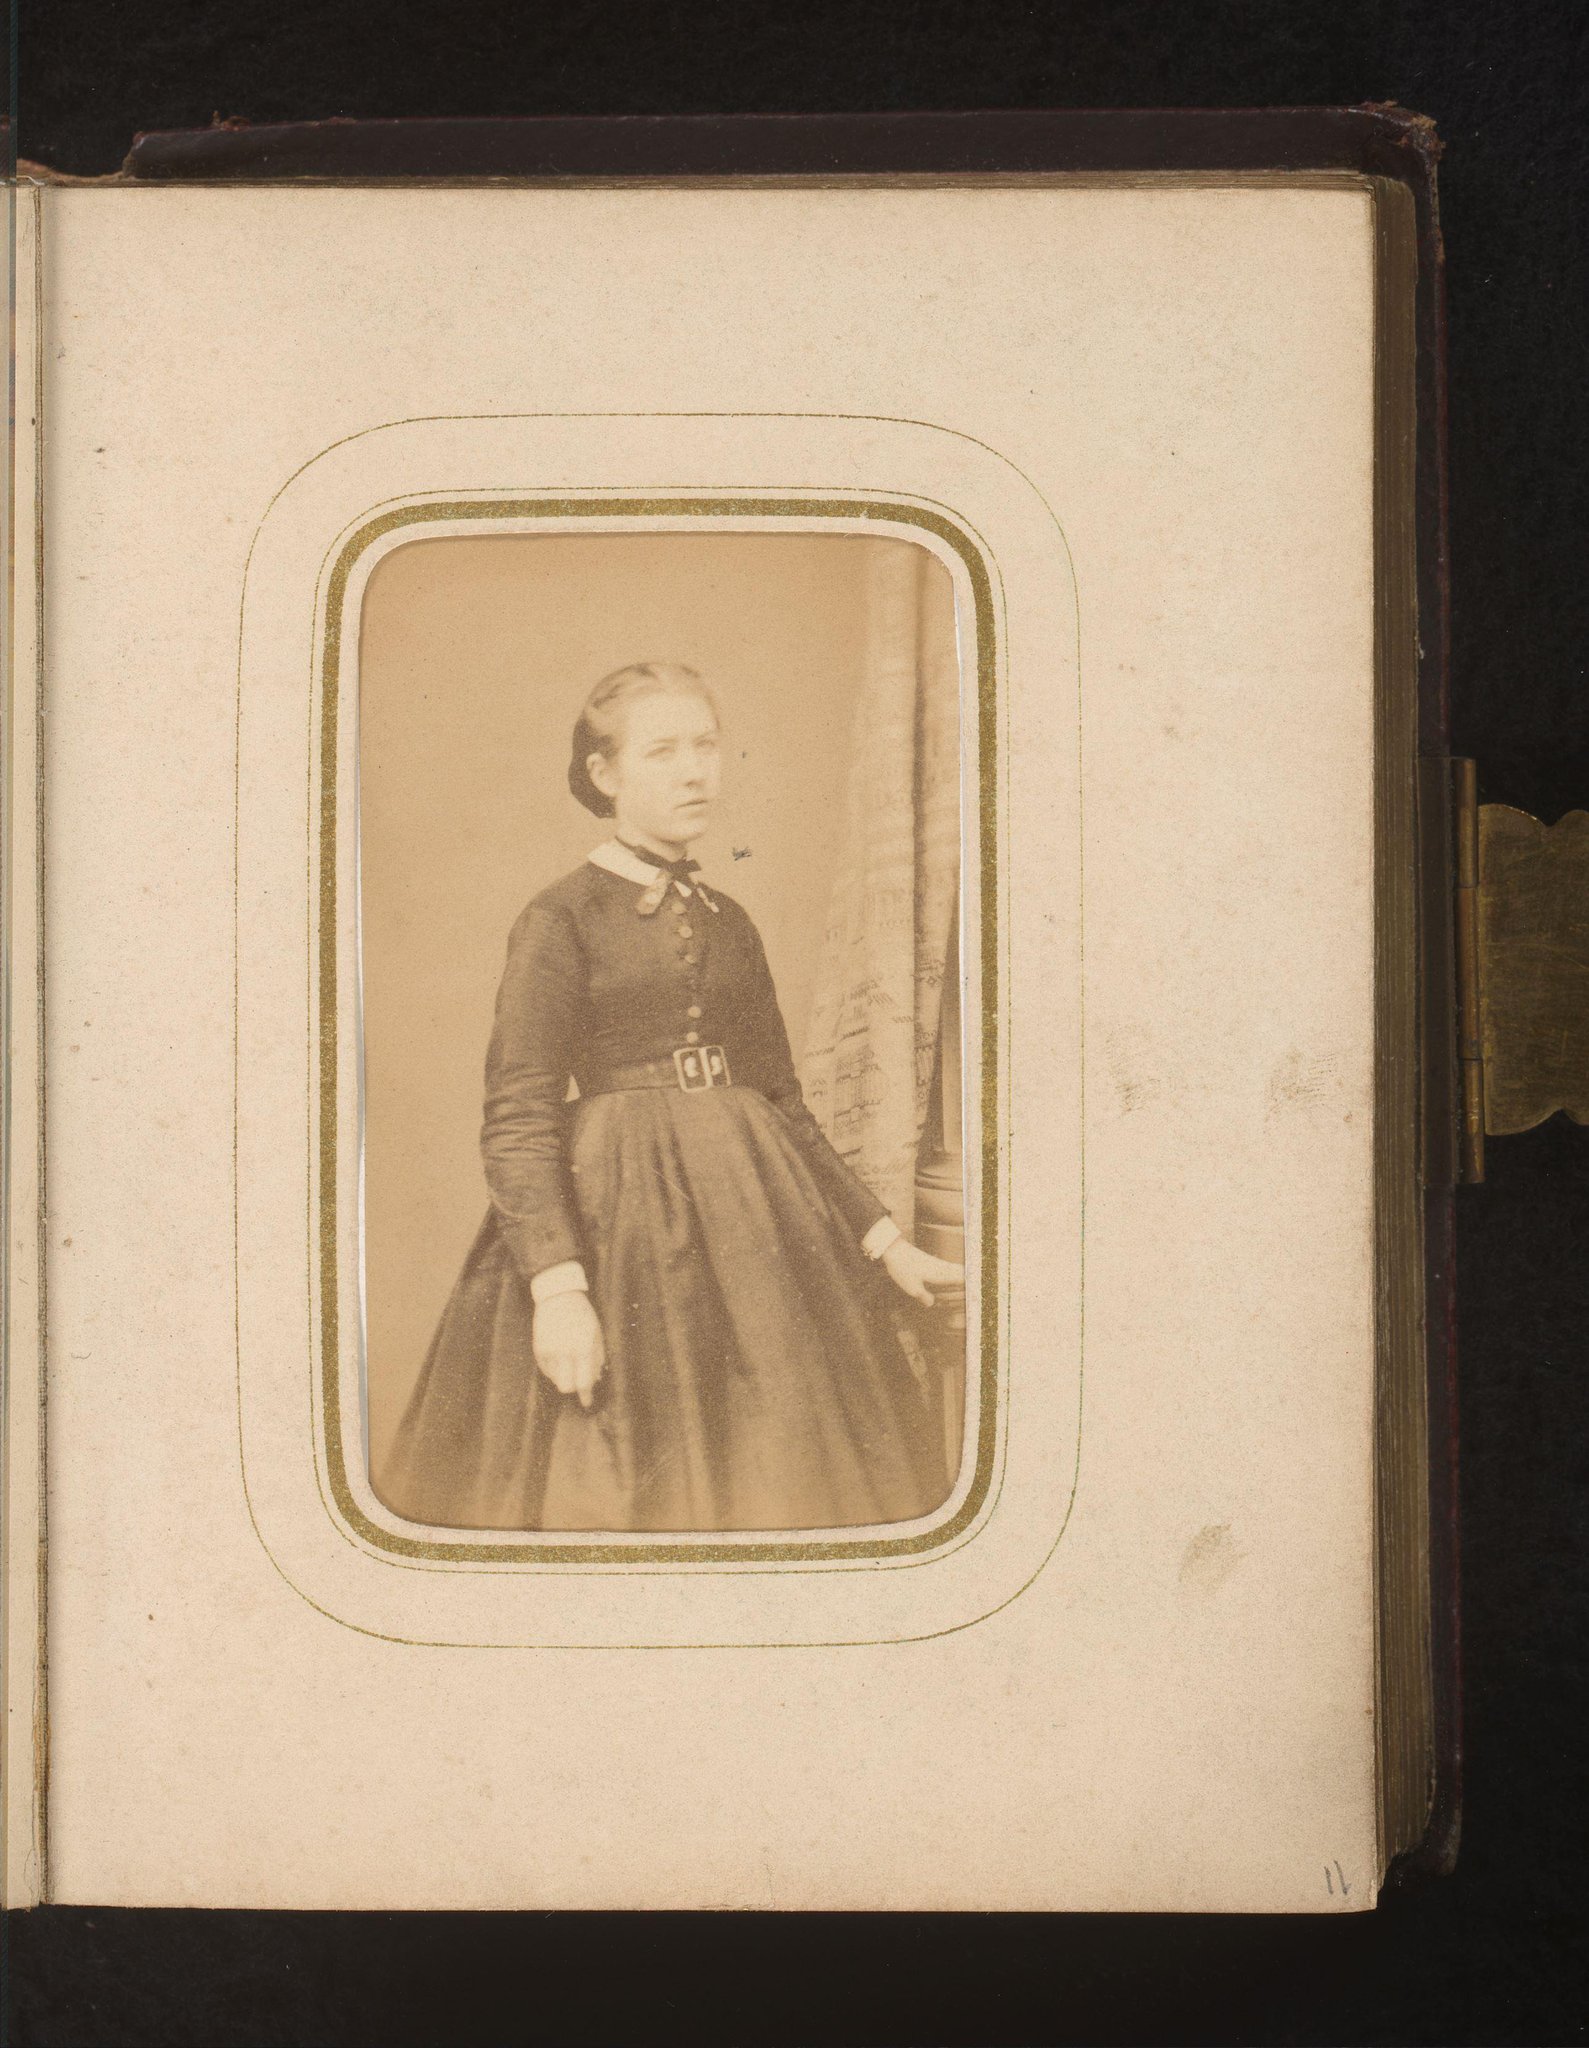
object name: carte de visite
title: Portret van een jonge vrouw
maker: Anonymous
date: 1860-1900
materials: cardboard, photographic support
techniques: albumen print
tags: adolescent, young woman, maiden